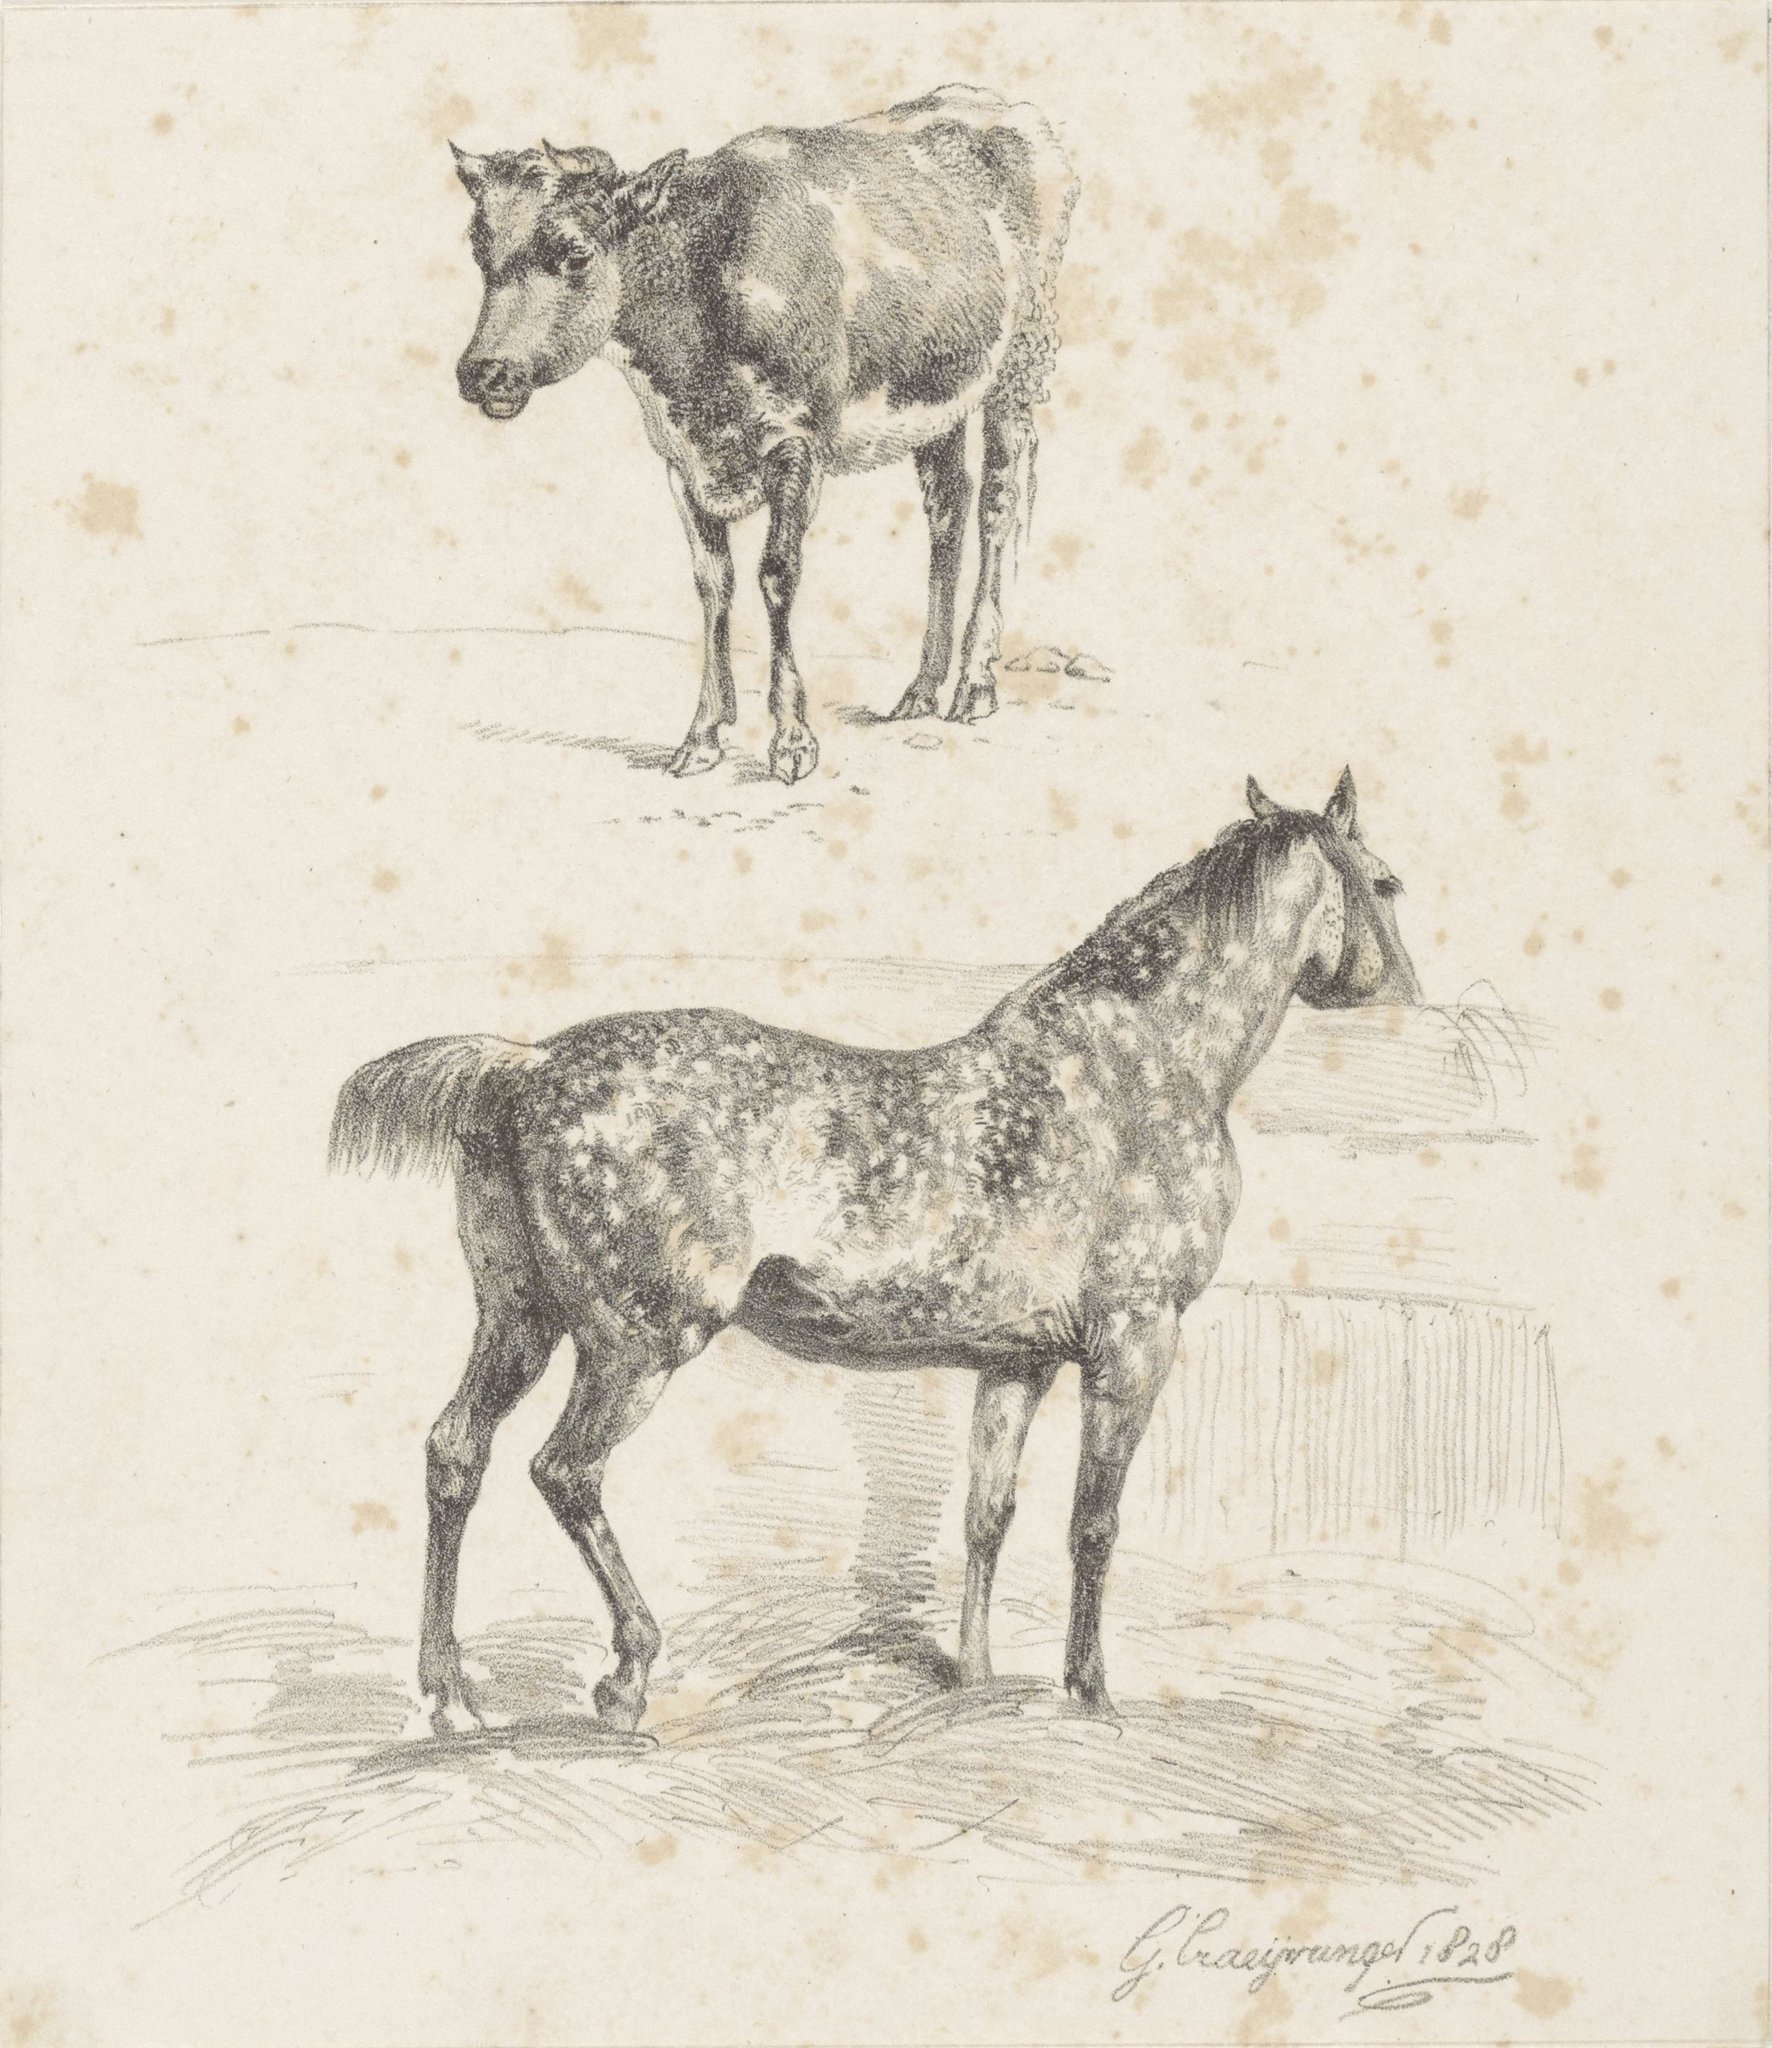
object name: print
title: Kalf en paard in stal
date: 1828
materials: paper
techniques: lithograph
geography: amsterdam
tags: horse (+ animals eating and drinking), calf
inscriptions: collector's mark: Lugt 2228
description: Waarschijnlijk is dit een prent voor: 'Beesten Studien naar het Leven op steen gebragt door G. Craeyvanger'. Amsterdam: Francois Buffa & Zoonen, 1828. Zie Swillens in Jaarboek Oud Utrecht. Volgens Swillens gedrukt door Ambroise Jobard. In Lijst van kunstwerken door beoefenaars en verzamelaars bijeengebragt, om verloot te worden ten behoeve van het vaderland; tentoongesteld te Amsterdam, in het nationale geregtshof, Amsterdam (C.A. Spin) 1831, p. 31, nr. 700 vermeld als uitgave van Daiwaille en Veldhuijzen. Daiwaille had eerder samengewerkt met Ambroise Jobard.